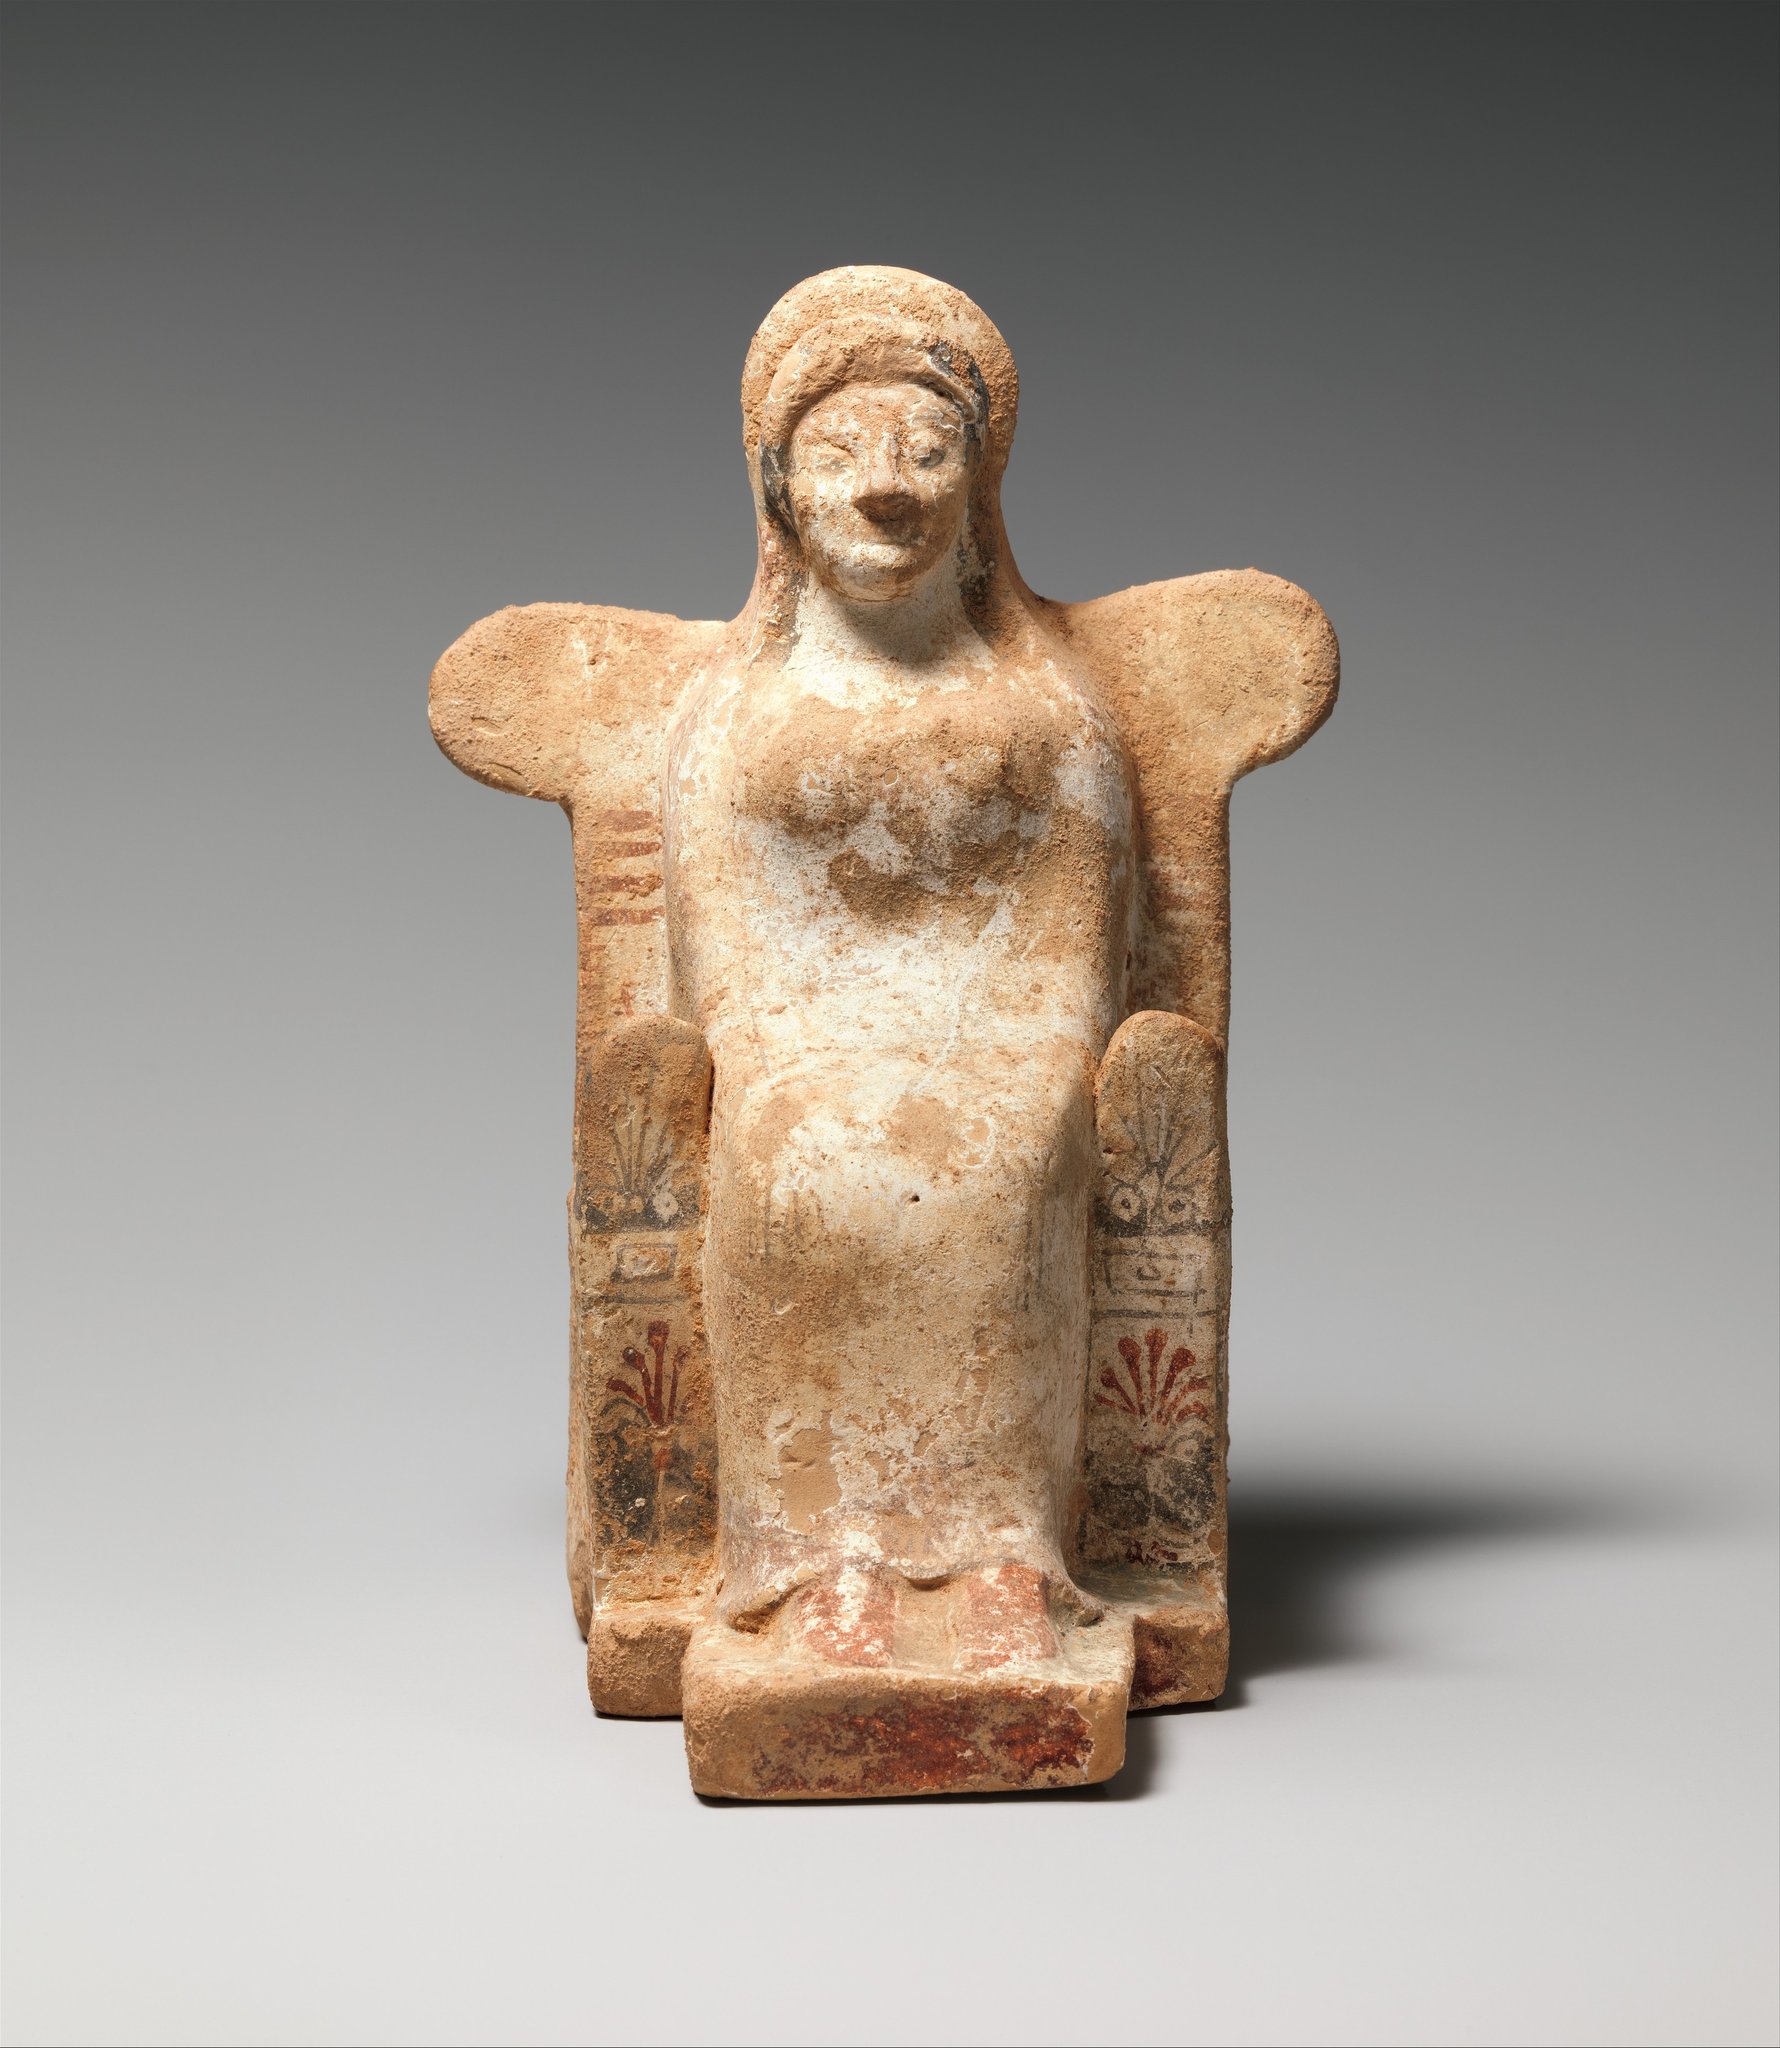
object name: seated woman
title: Terracotta statuette of a seated woman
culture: greek, boeotian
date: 534-468 BCE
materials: terracotta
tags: women